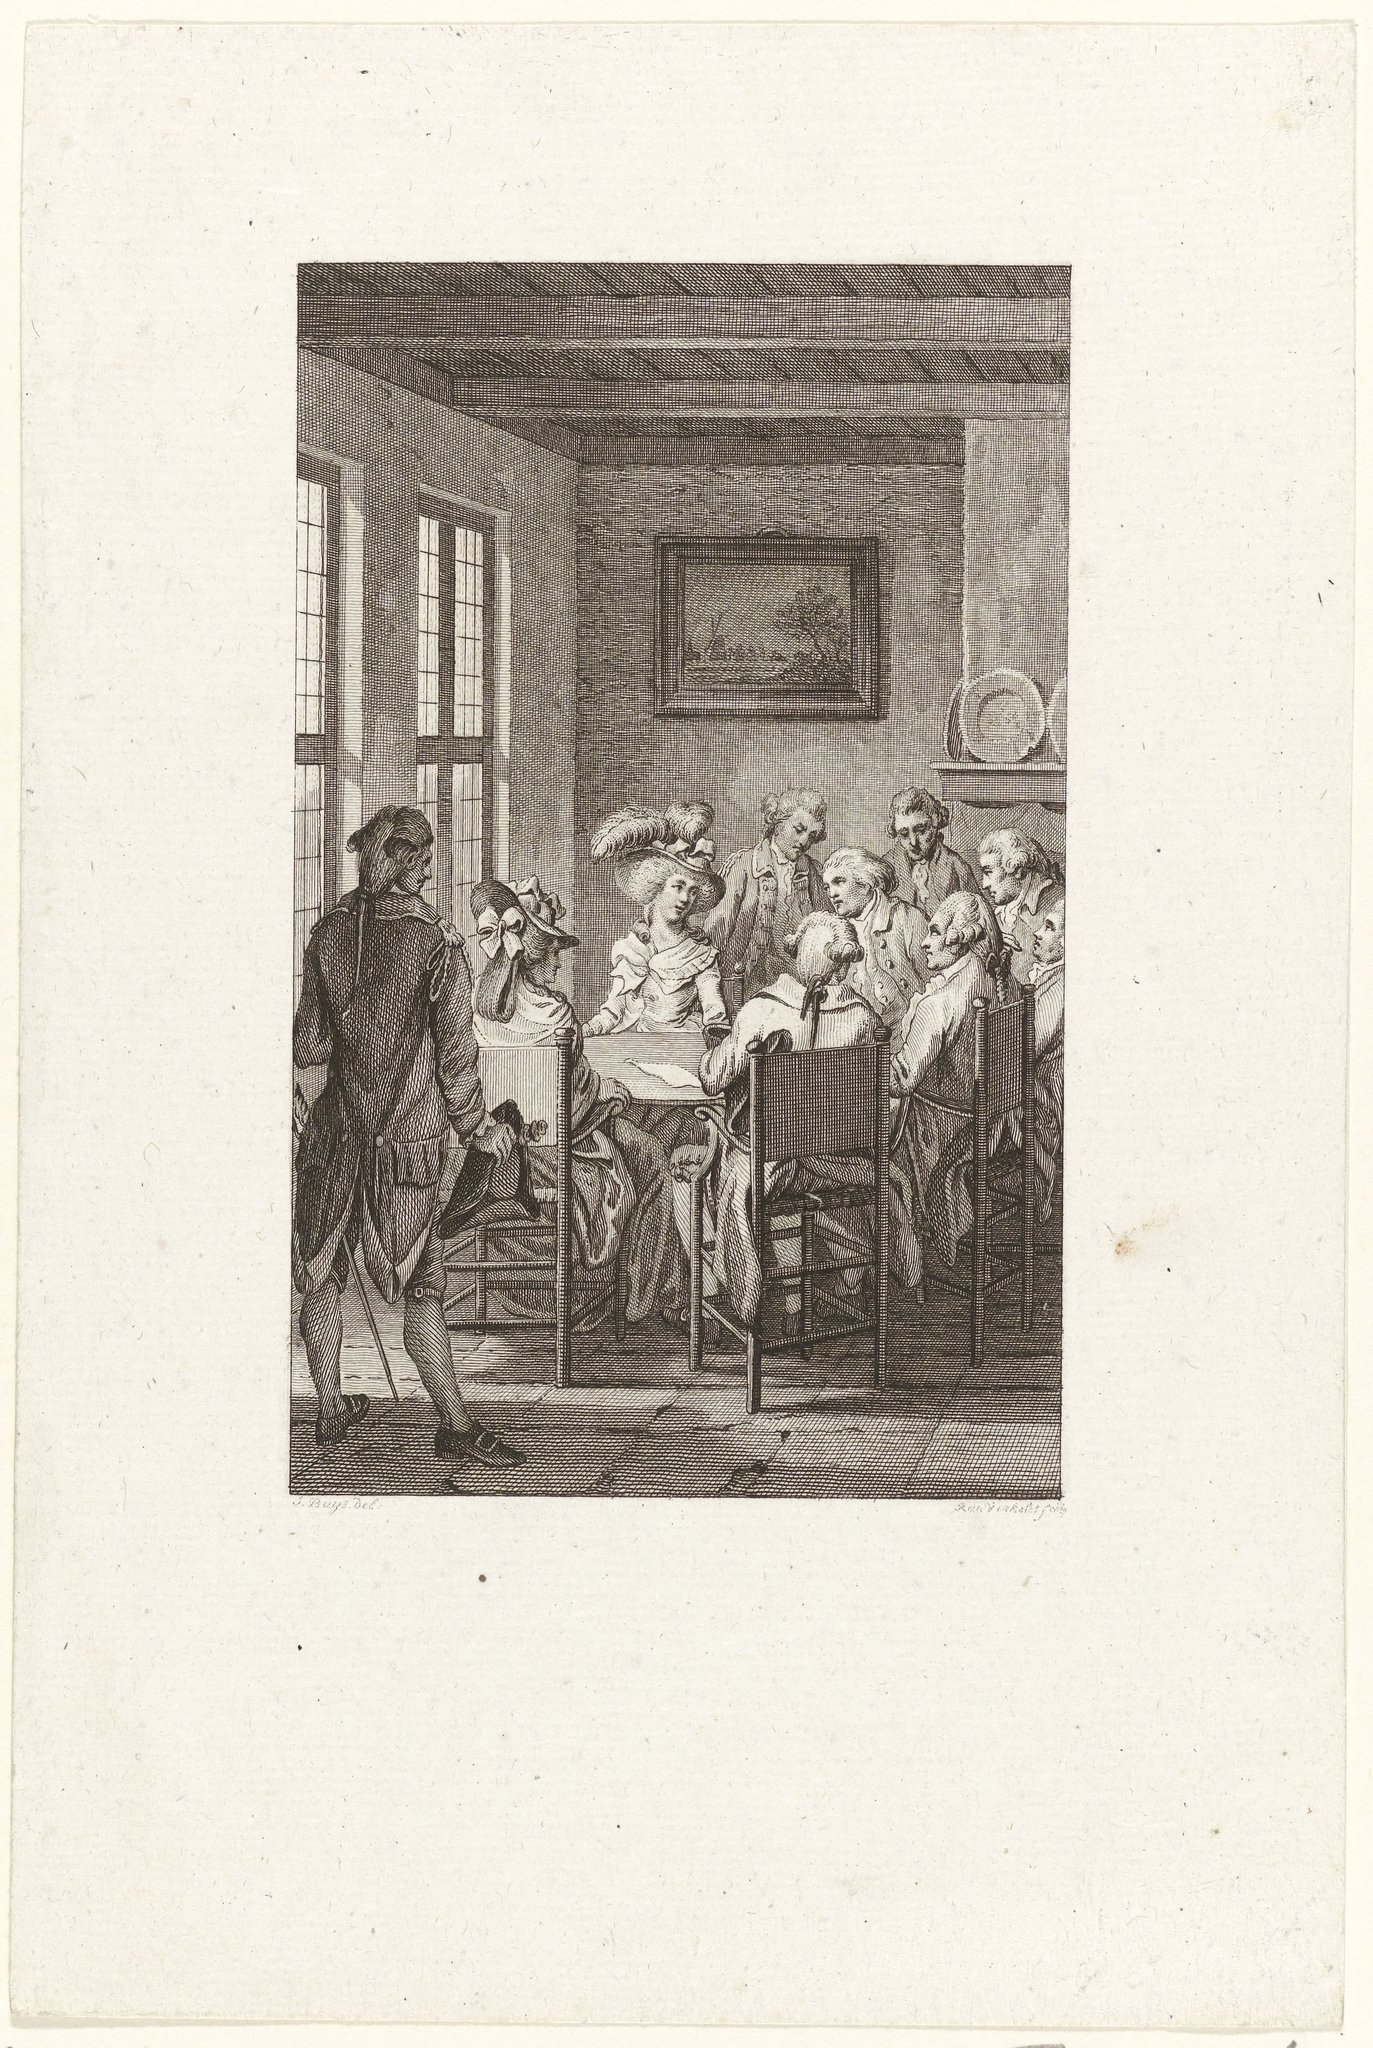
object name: print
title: Onderhoud met de prinses te Goejanverwellesluis, 1787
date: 1795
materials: paper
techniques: engraving, etching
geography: northern netherlands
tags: berlin, painter, draughtsman, wilhelmina of prussia (princess of orange), arrest (of criminal)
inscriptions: collector's mark: Lugt 2228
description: Gebruikt als illustratie in: P.A. Loosjes, Vaderlandsche historie, vervattende de geschiedenissen, der Vereenigde Nederlanden (...). Ten onmiddelyken vervolge van Wagenaar's Vaderlandsche historie.